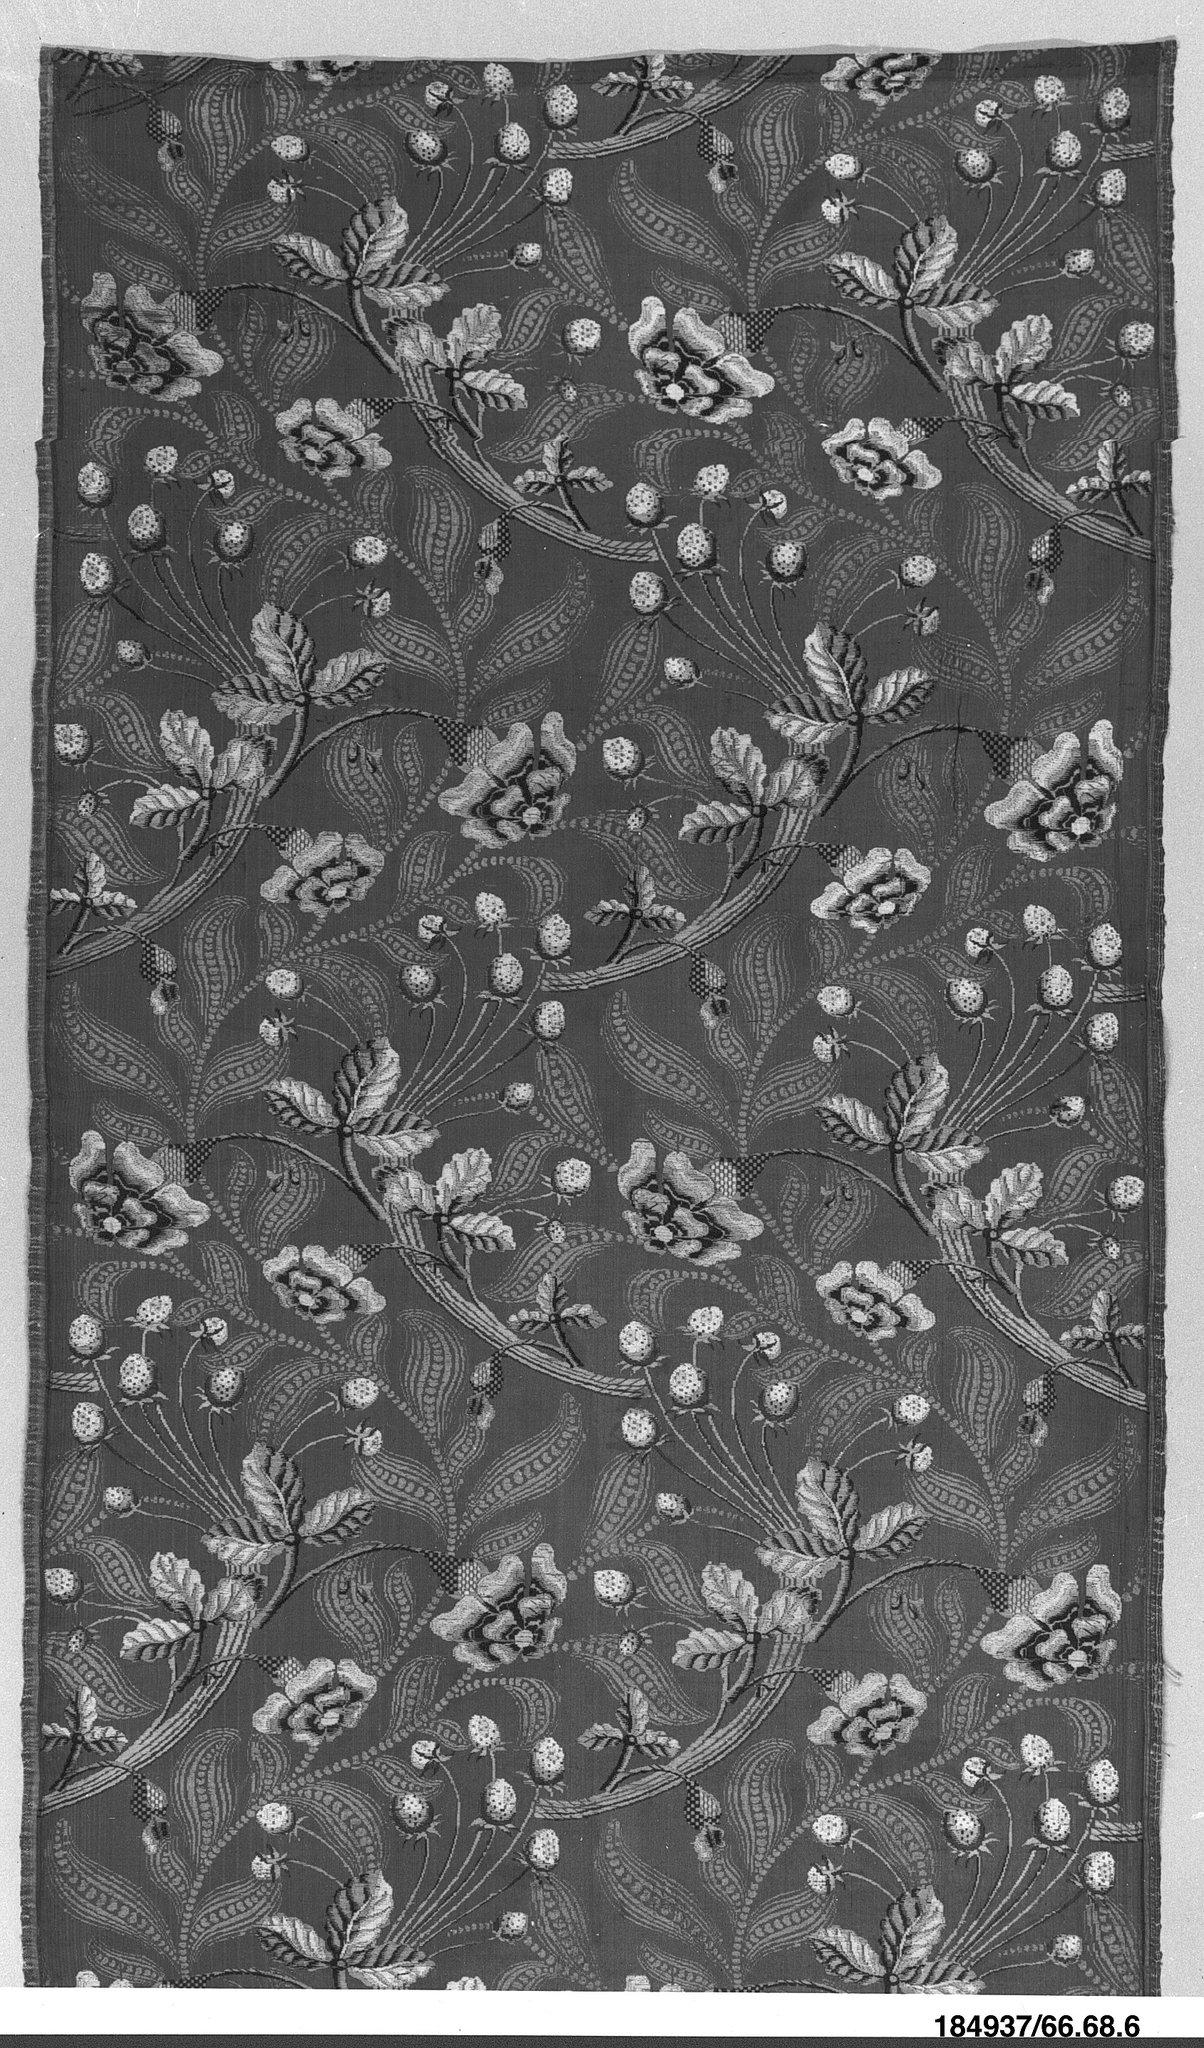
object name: piece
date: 1701-1800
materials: silk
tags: flowers,leaves